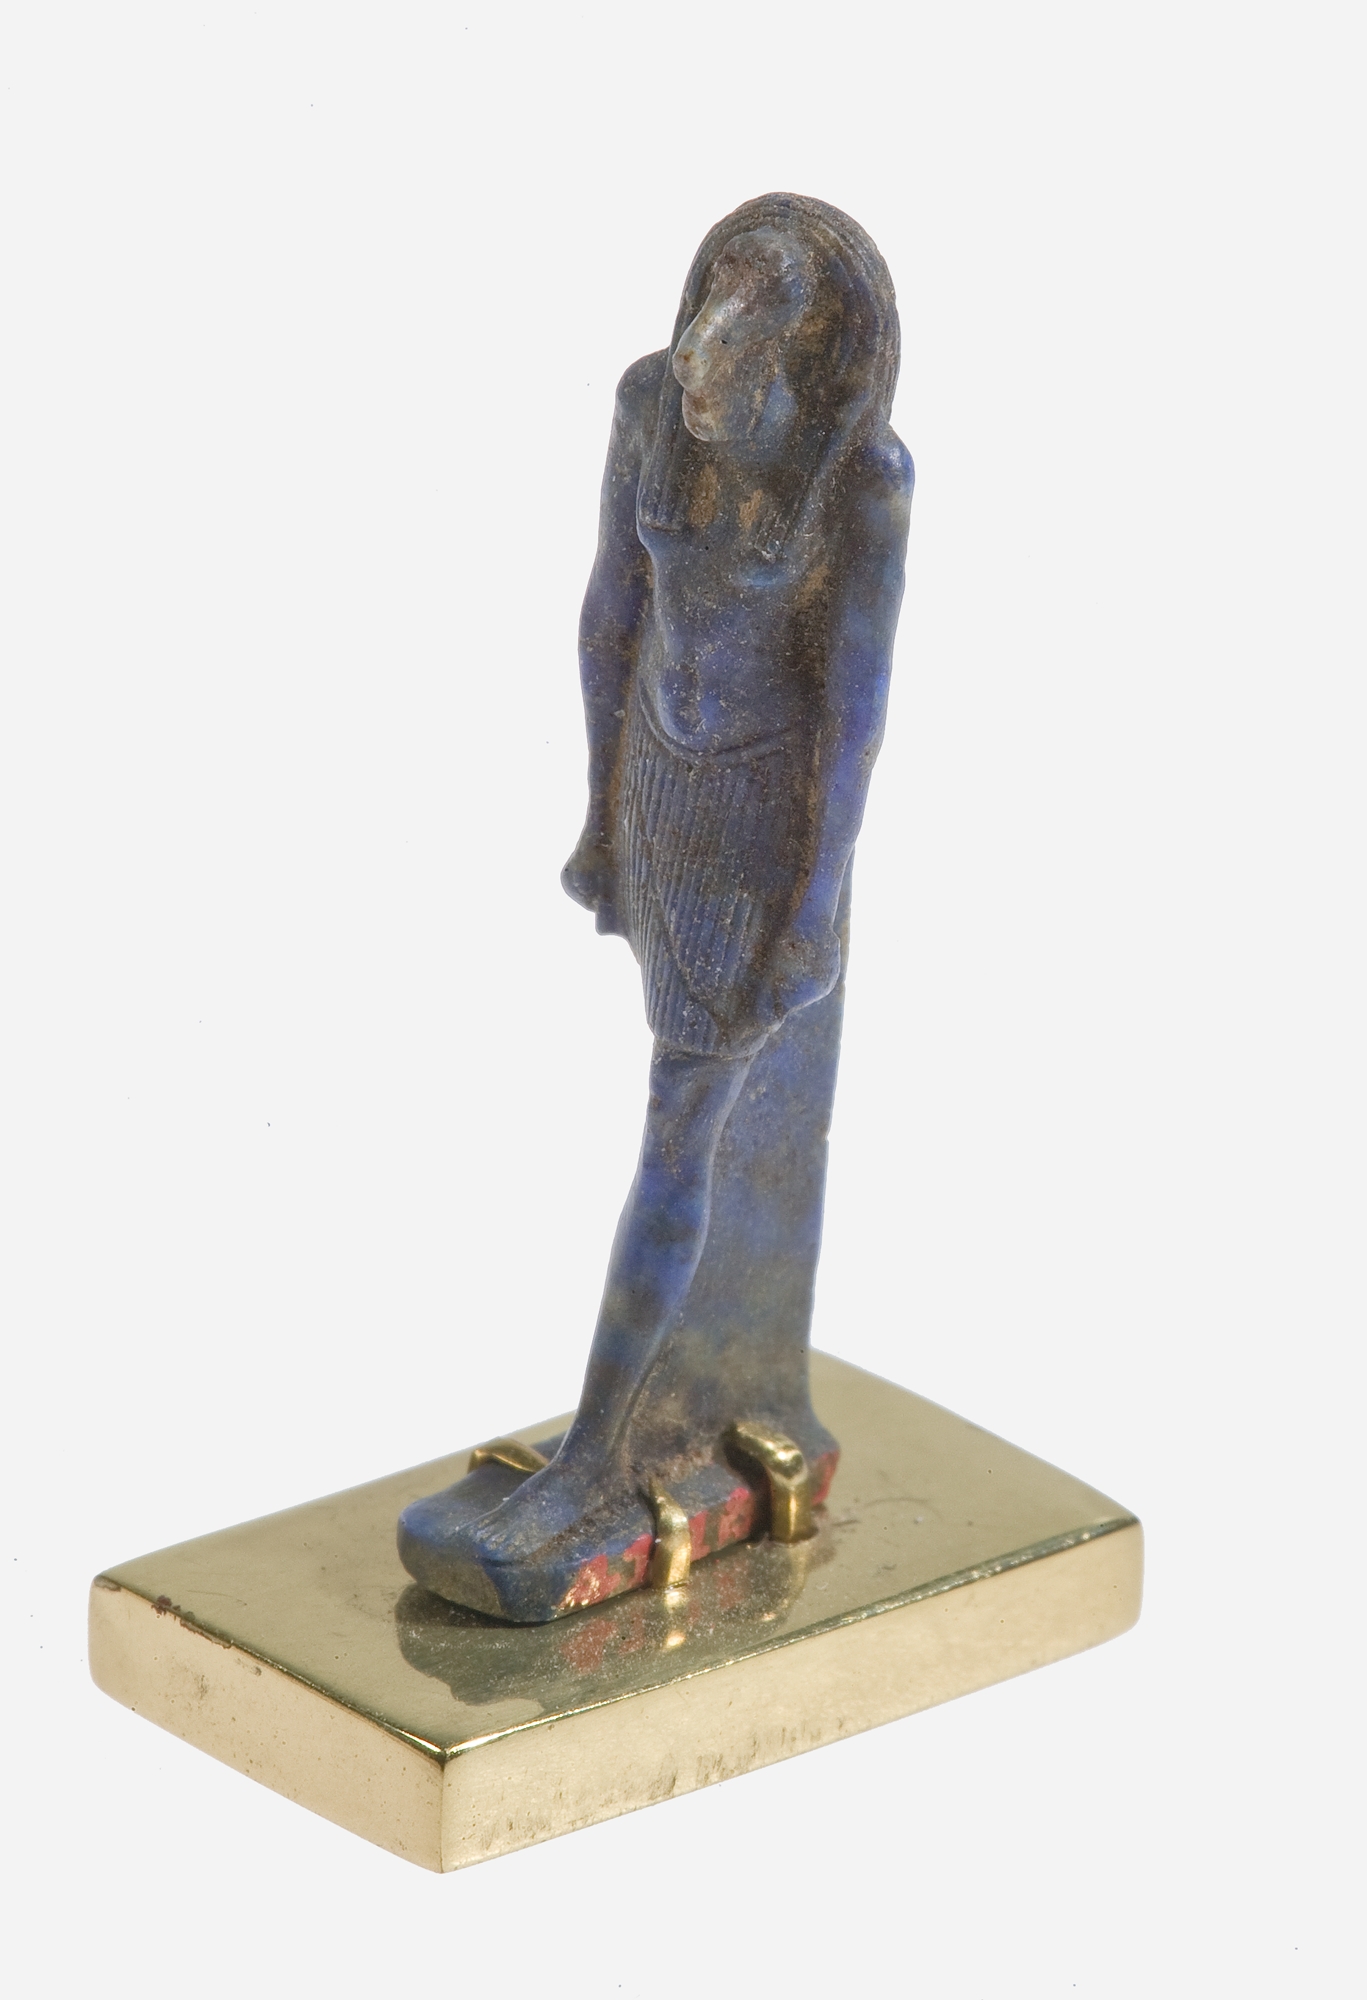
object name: amulet, thoth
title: Thoth amulet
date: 664-332 BCE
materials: lapis lazuli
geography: egypt